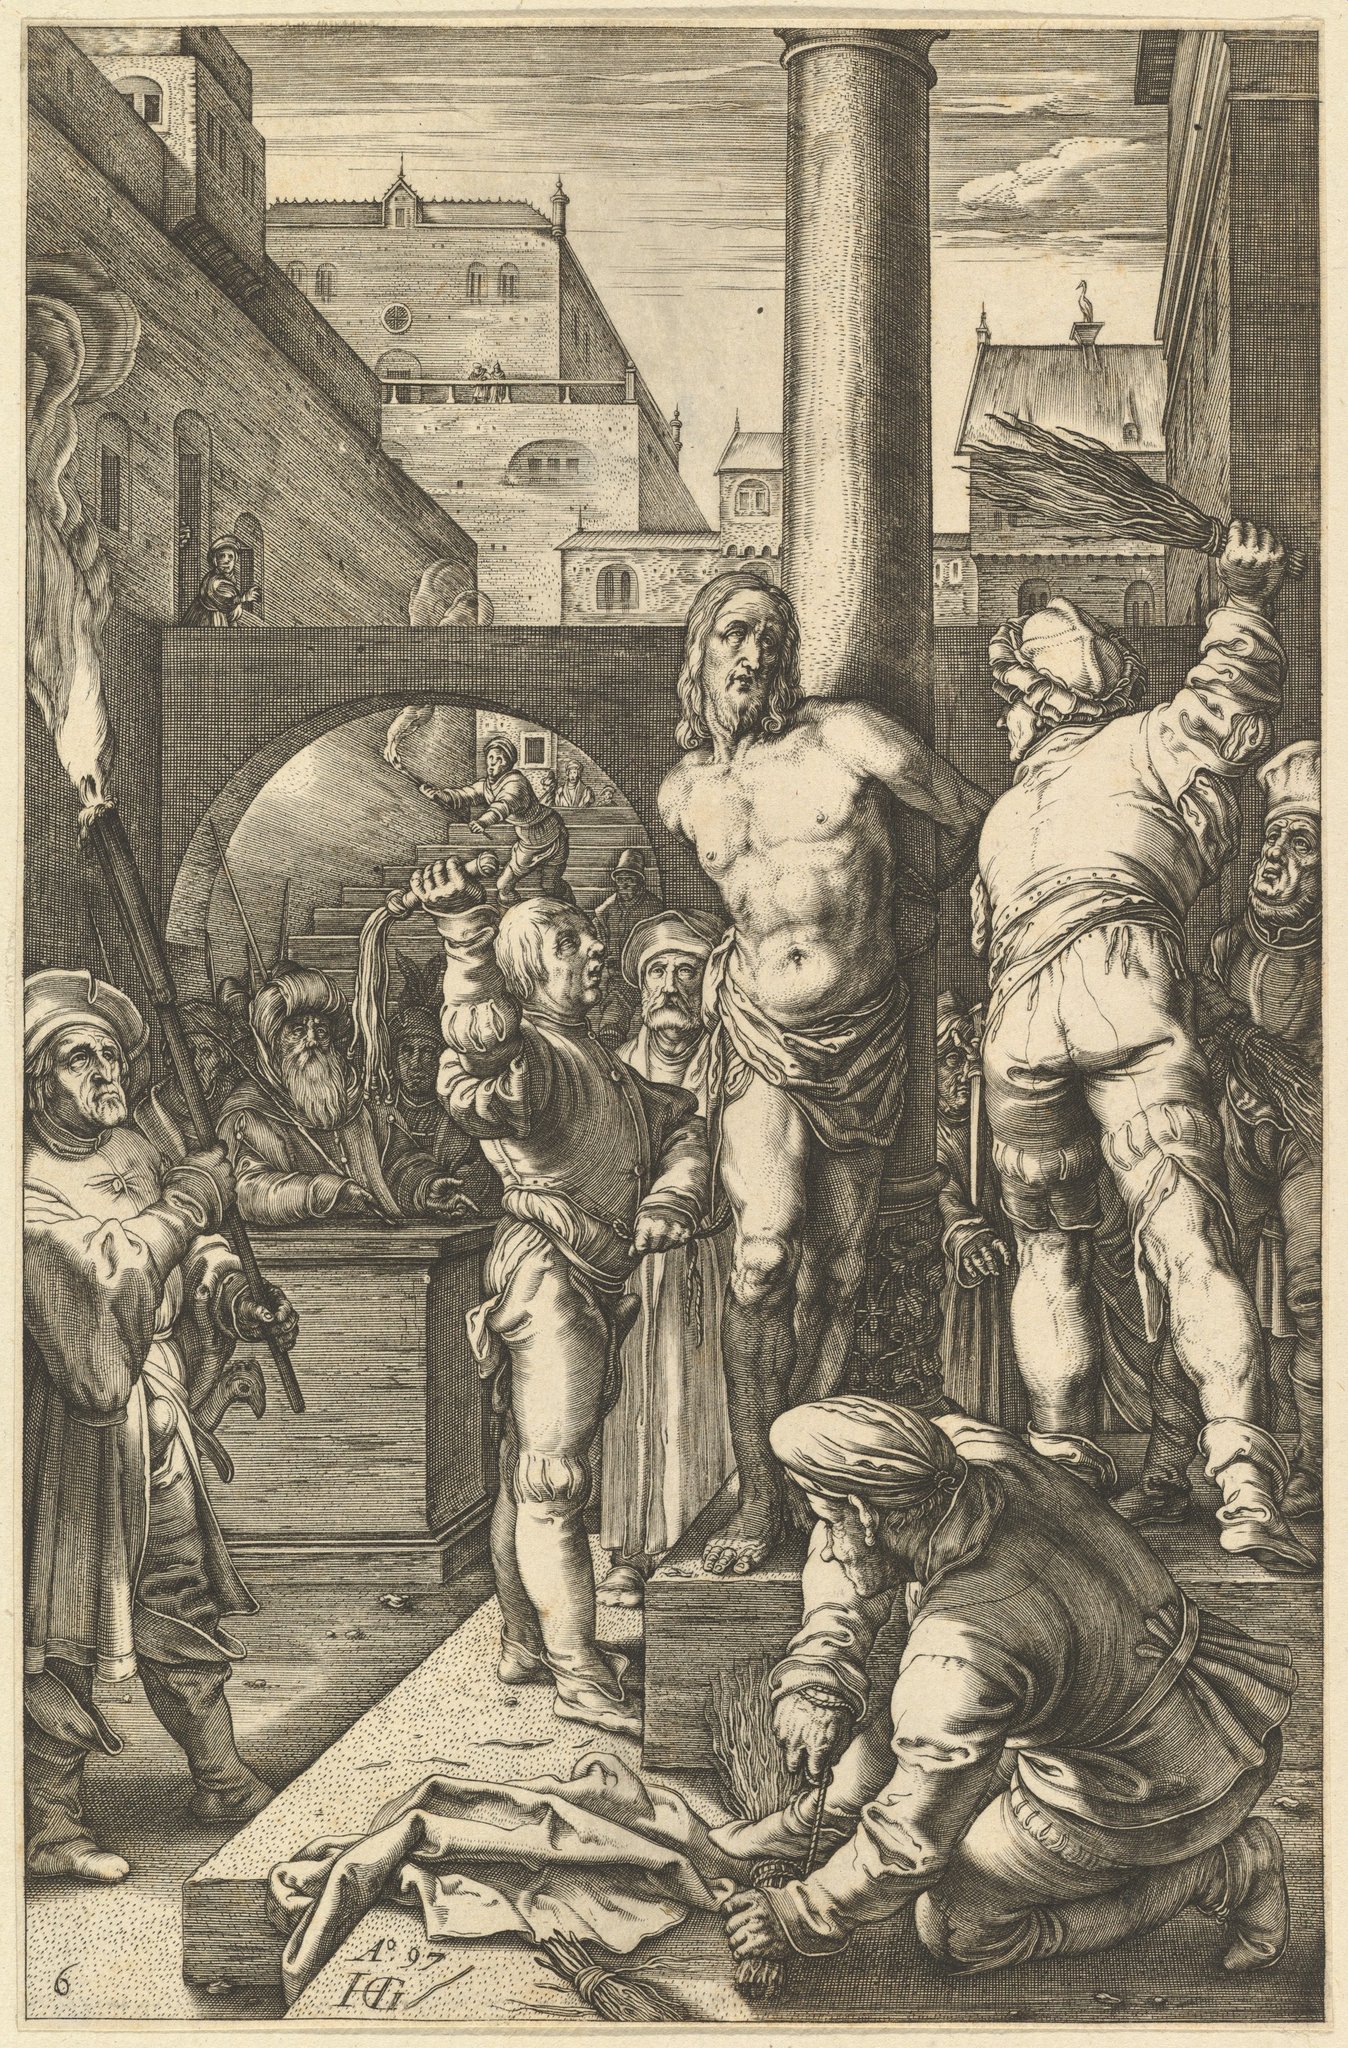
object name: print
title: The Flagellation, from "The Passion of Christ"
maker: Anonymous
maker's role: artist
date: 1598-1617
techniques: engraving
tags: christ